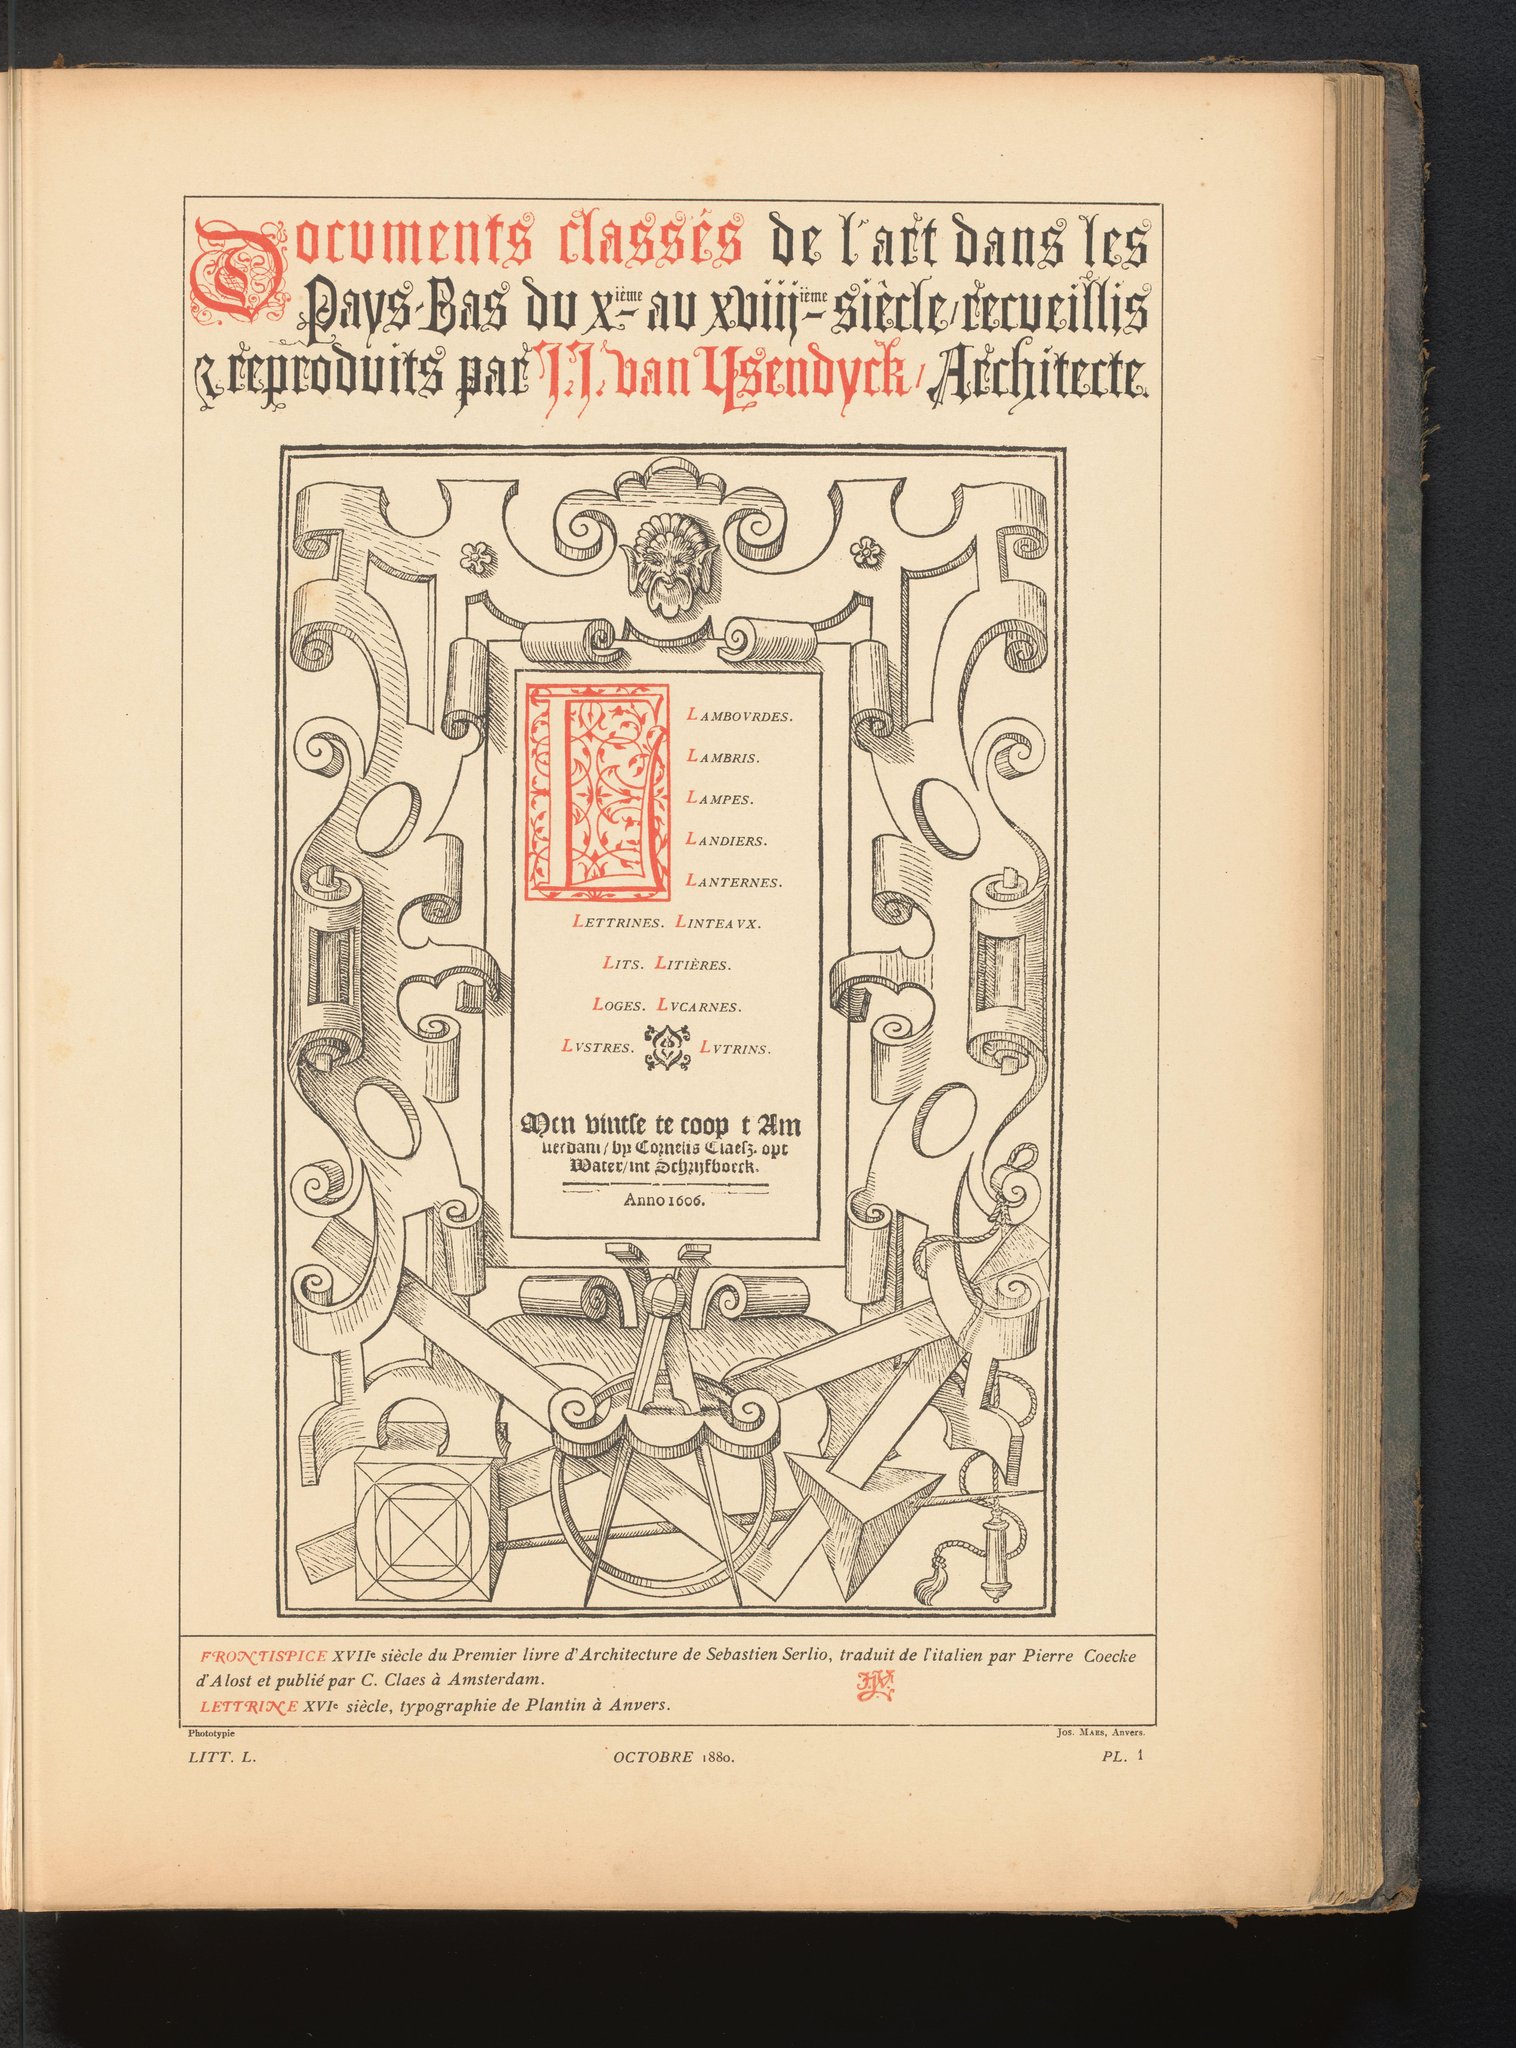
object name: reproduction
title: Reproductie van een titelpagina van een serie boeken over architectuur van Sebastiano Serlio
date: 1875-1880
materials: paper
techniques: photolithography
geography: antwerp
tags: ornament ~ grotesque, title-page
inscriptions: inscription: ‘FRONTISPICE XVIIe siècle (...)’, inscription: ‘LITT. L. - OCTOBRE 1880. - PL. 1’, monogram: ‘JJvY’